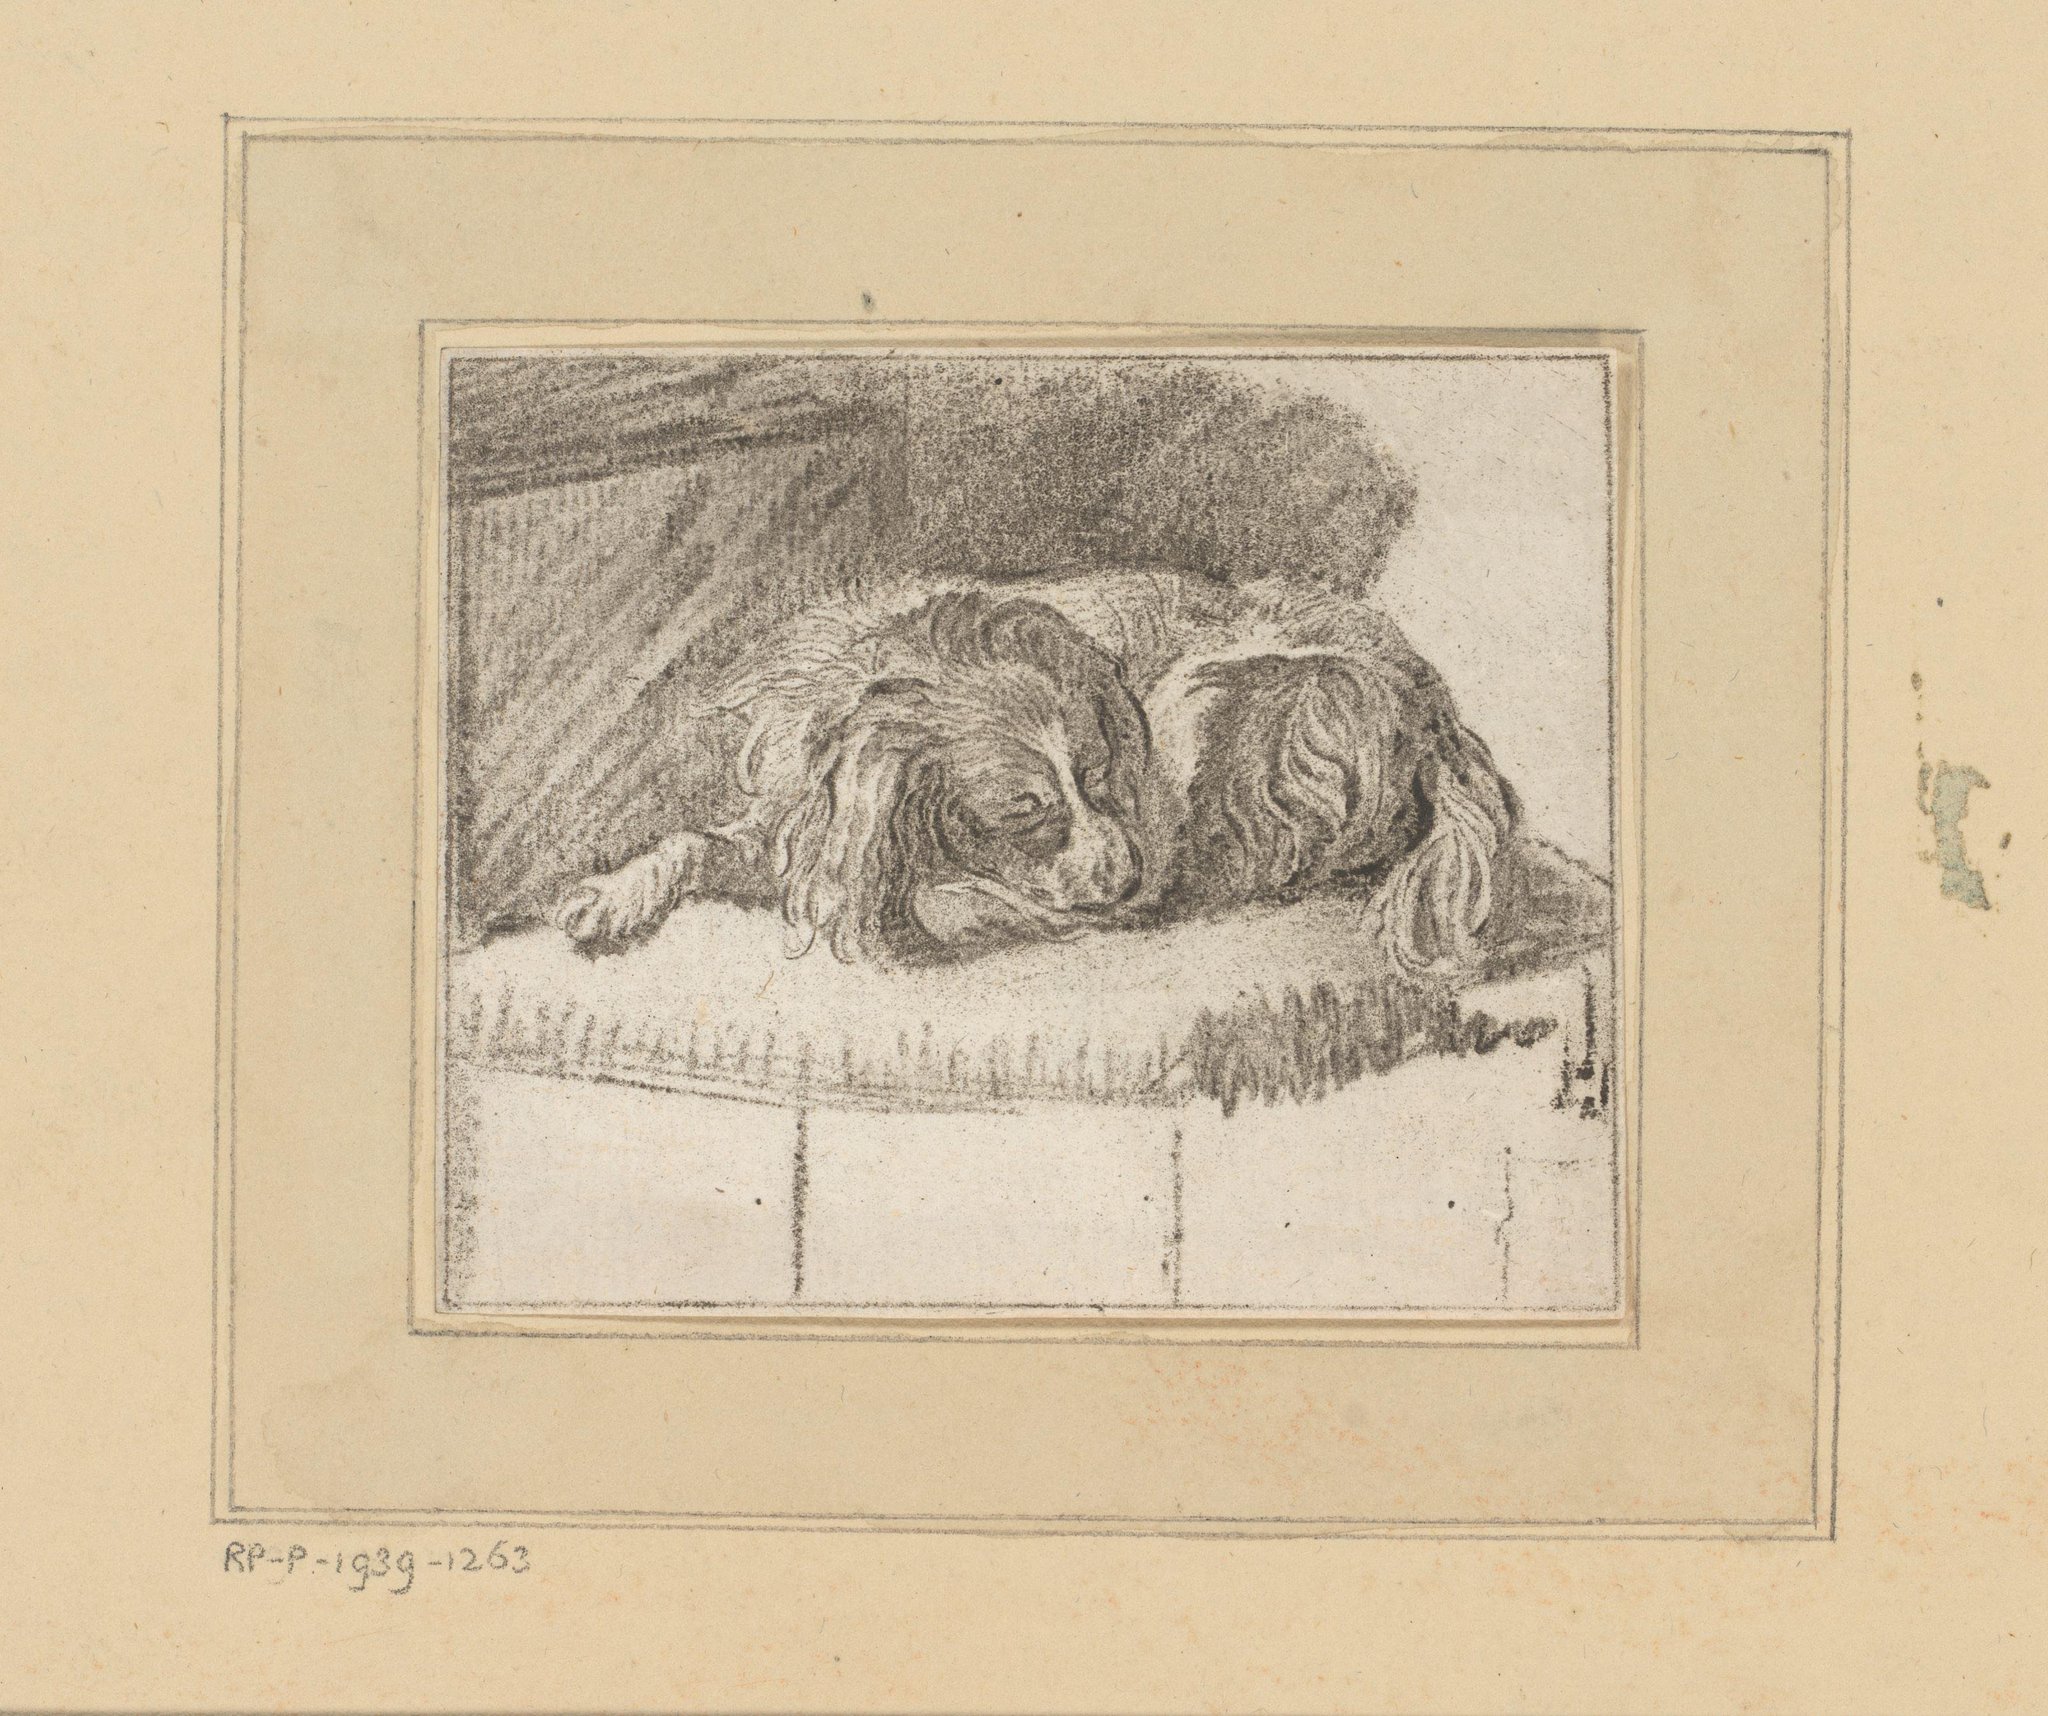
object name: print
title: Liggende hond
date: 1777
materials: paper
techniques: printmaking, etching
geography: amsterdam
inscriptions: inscription: ‘Fr. v. Mieris del. 1663. Ploos v. Amstel J.C. F. 1777’, collector's mark: ‘RIJKS / MUSM’, collector's mark: Lugt 2725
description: De prent ligt los in een album, zie blad 27.